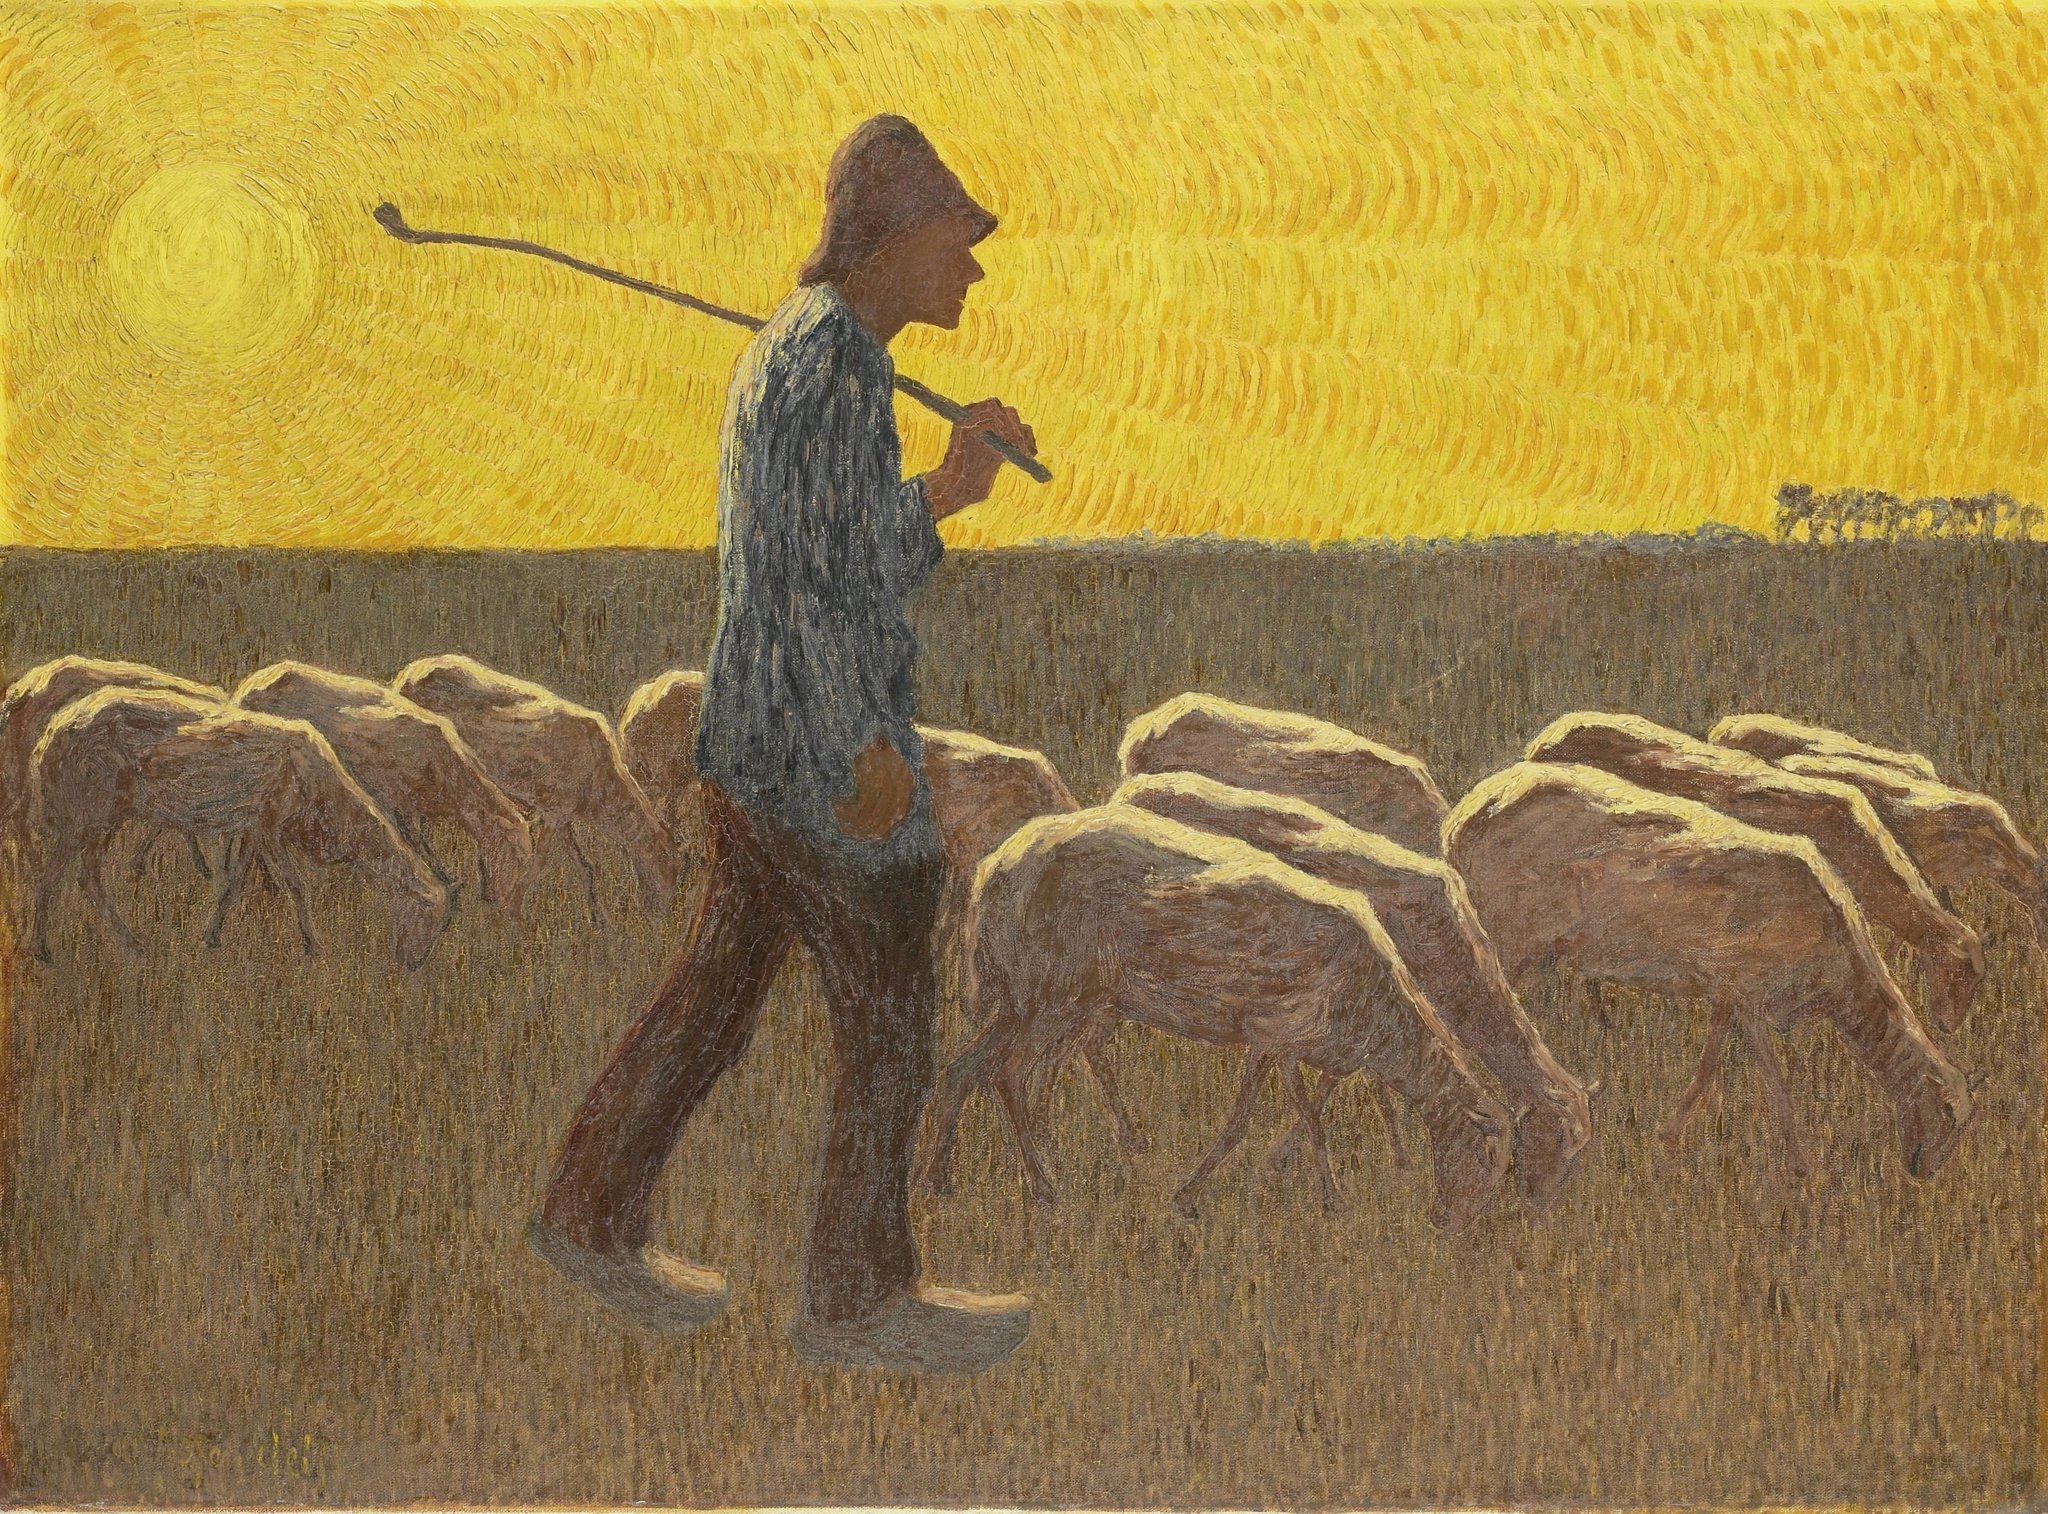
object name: painting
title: Shepherd with Sheep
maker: cornelis albert van assendelft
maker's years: 1870-1945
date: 1900-1945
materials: canvas, oil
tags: ambassador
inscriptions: signature: ‘C. van Assendelft’